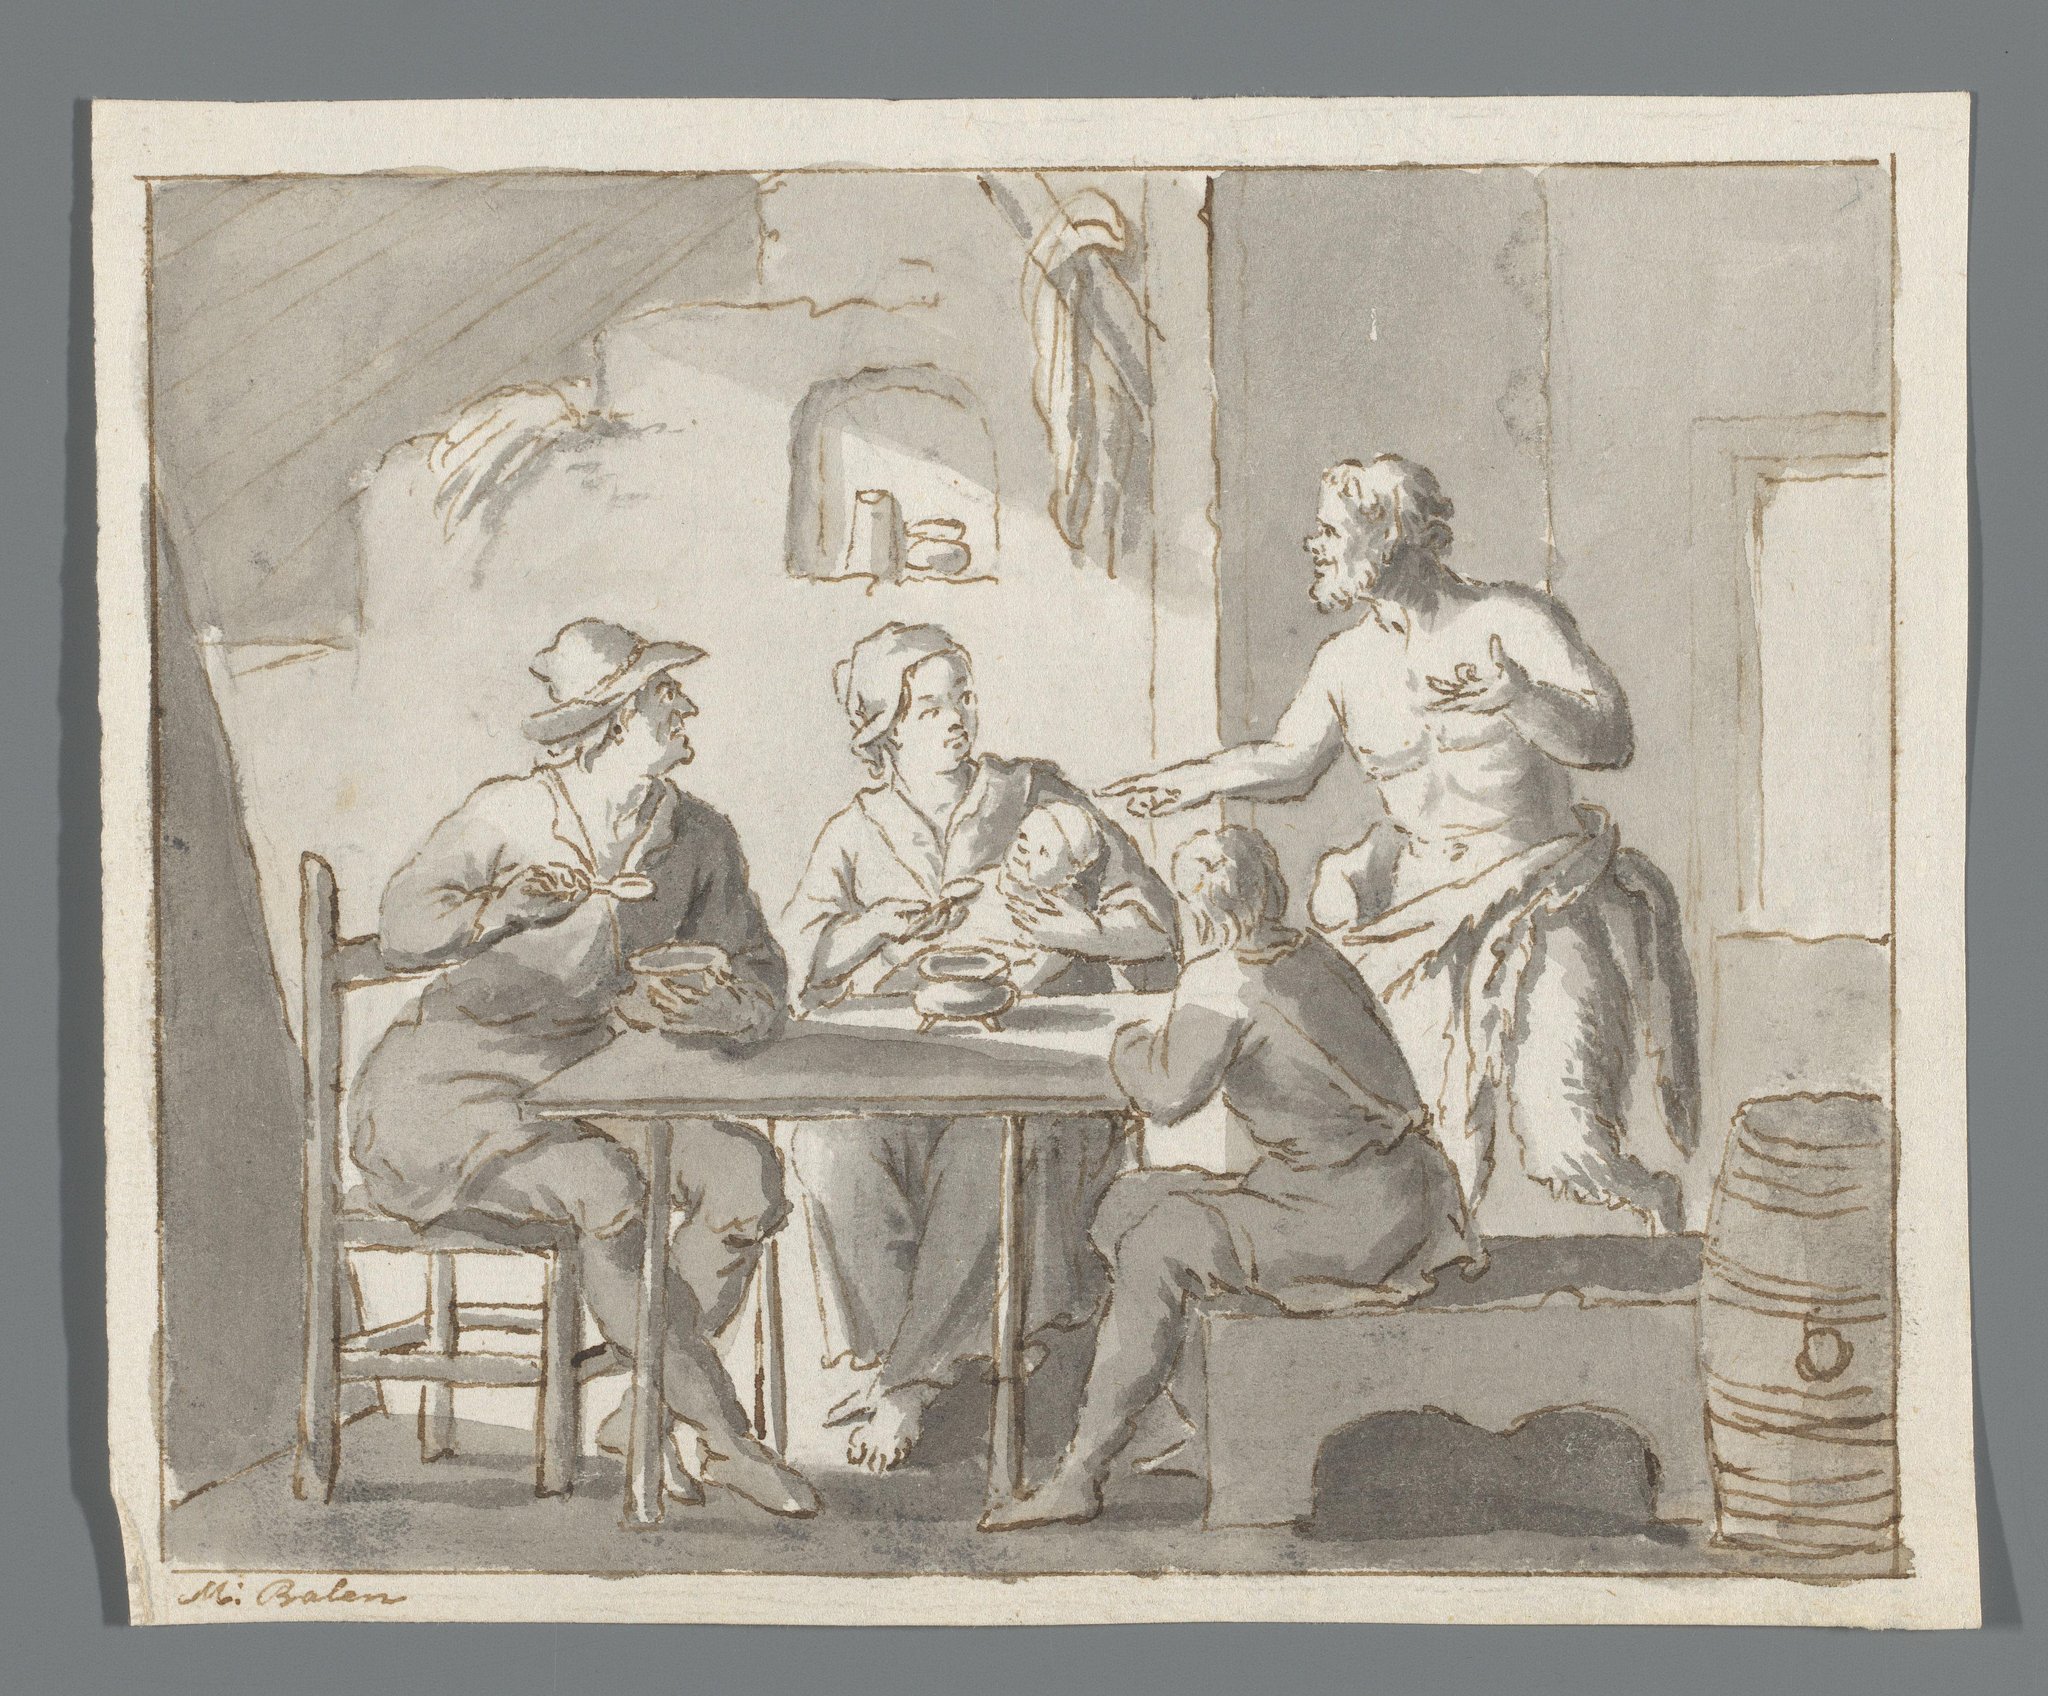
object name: drawing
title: Fabel van de sater en de boer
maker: matthijs balen (1684-1766)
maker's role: draughtsman, painter, print maker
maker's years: 1684-1766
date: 1694-1766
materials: paper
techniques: brush, pen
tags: the satyr and the peasants; according to aesop: the satyrs and the peasant (meal, blowing to cool food, etc.)